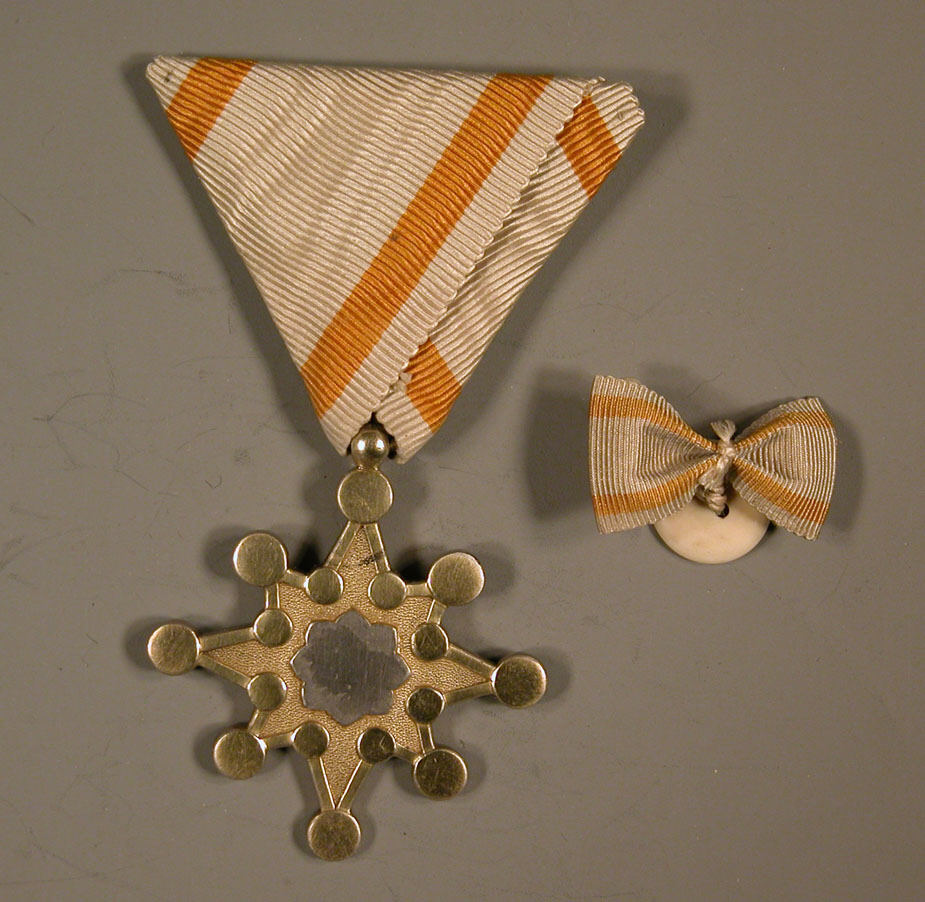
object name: insignia and button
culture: japanese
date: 1867-1900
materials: ribbon